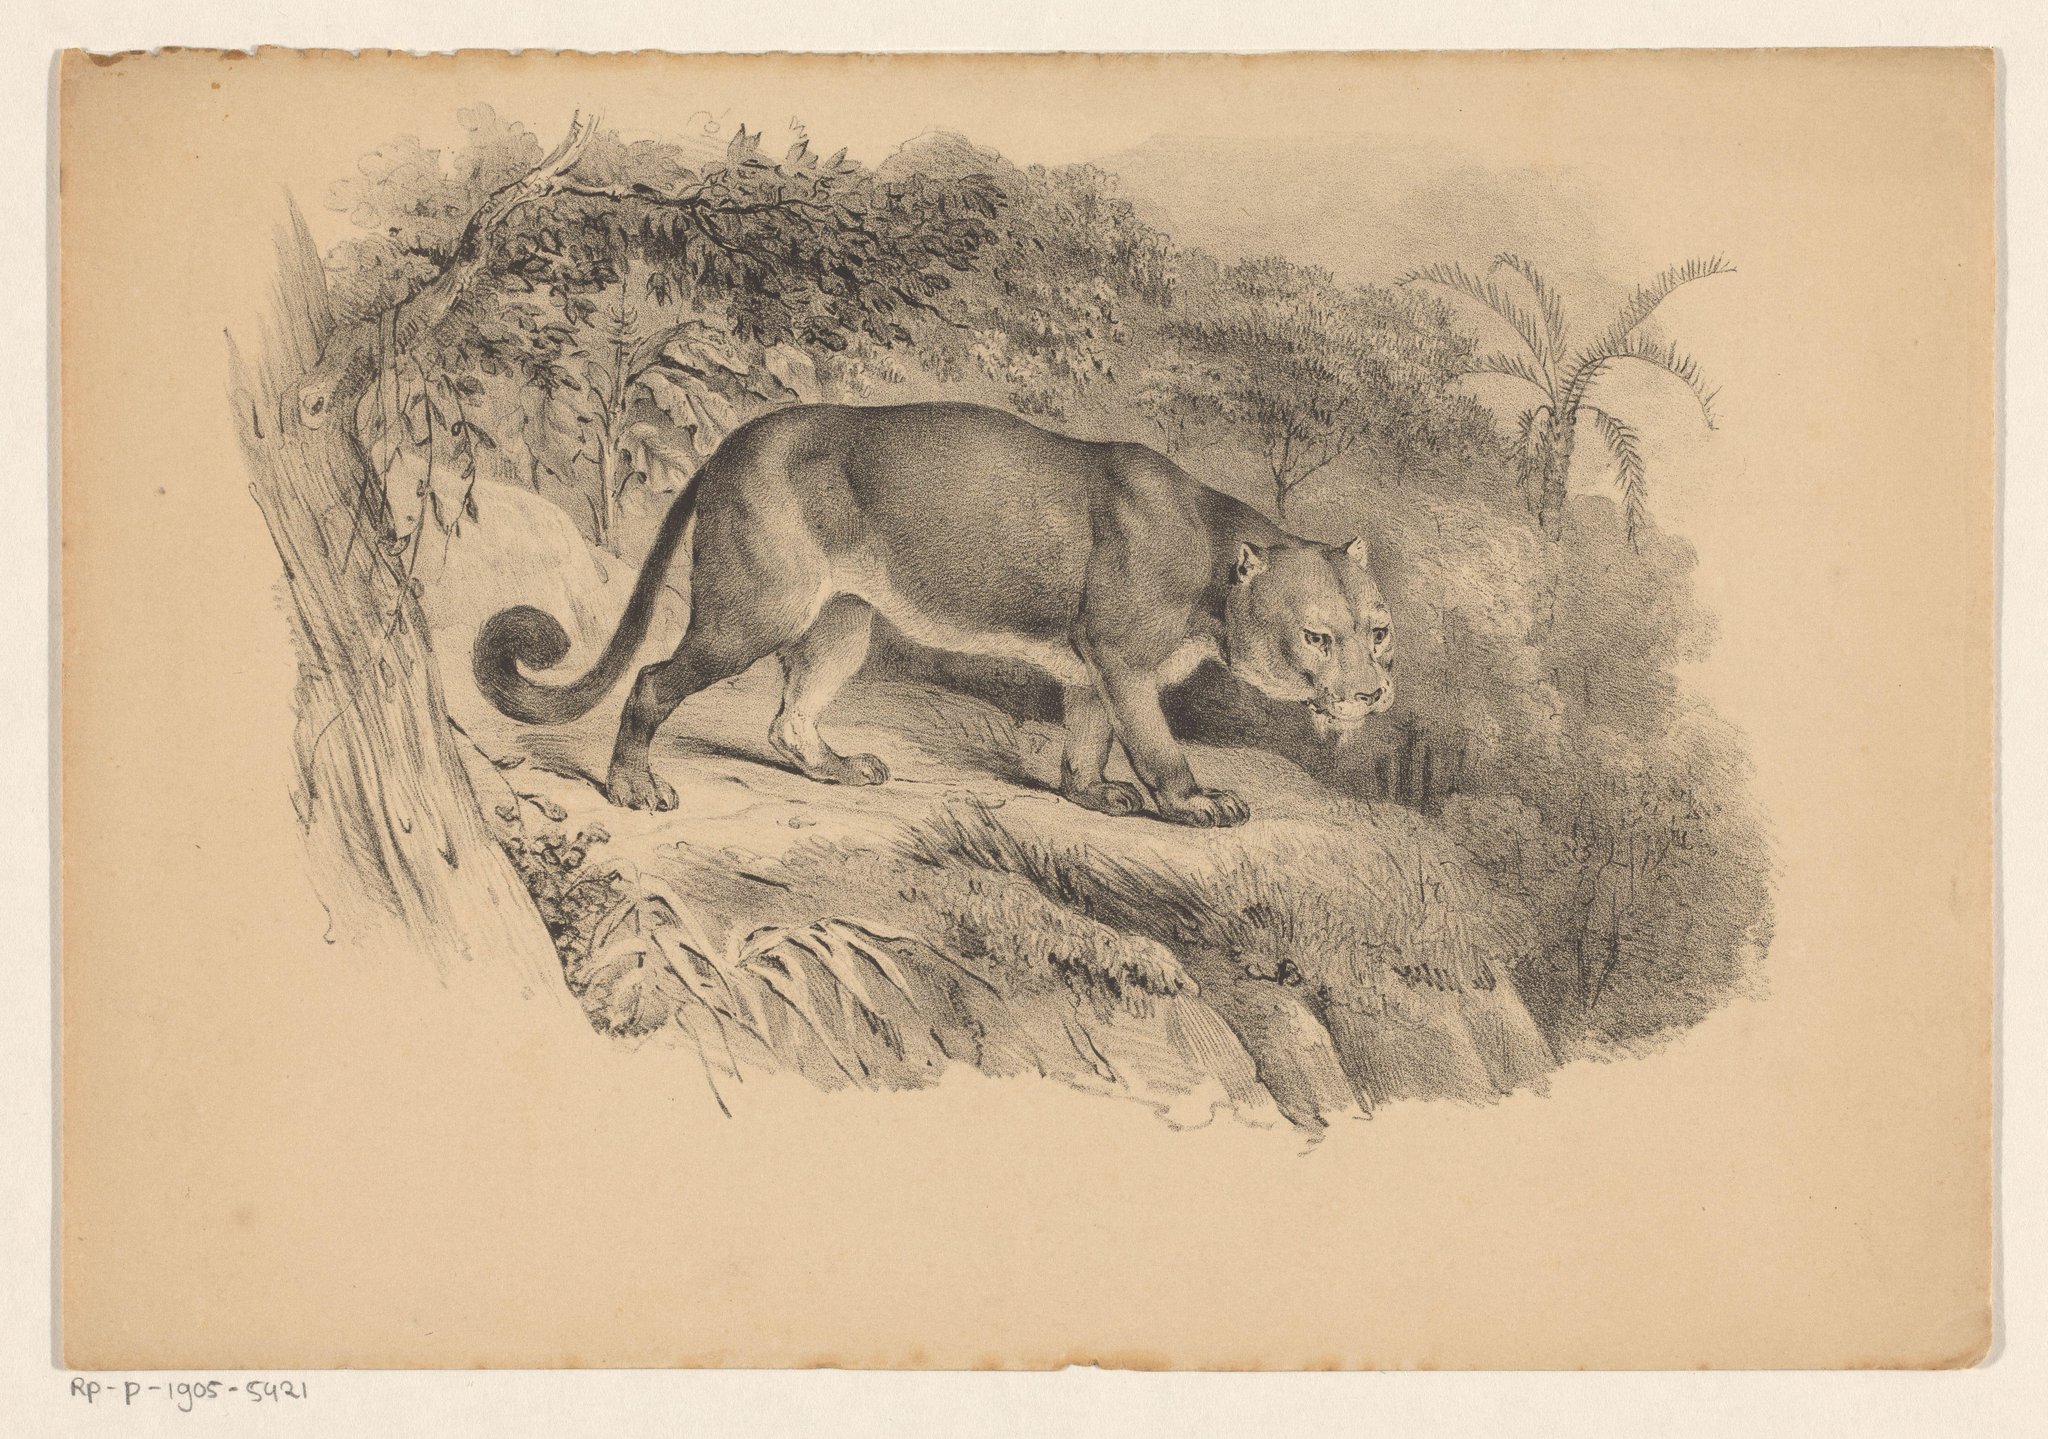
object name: print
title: Koegoear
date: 1842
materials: paper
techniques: lithograph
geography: netherlands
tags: beasts of prey, predatory animals: puma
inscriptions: collector's mark: Lugt 2228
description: Deze prent verscheen in: Schlegel, H. De Diergaarde en het Museum van het genootschap Natura Artis Magistra te Amsterdam. Amsterdam, M. Westerman & Zoon, 1842, p. 144.